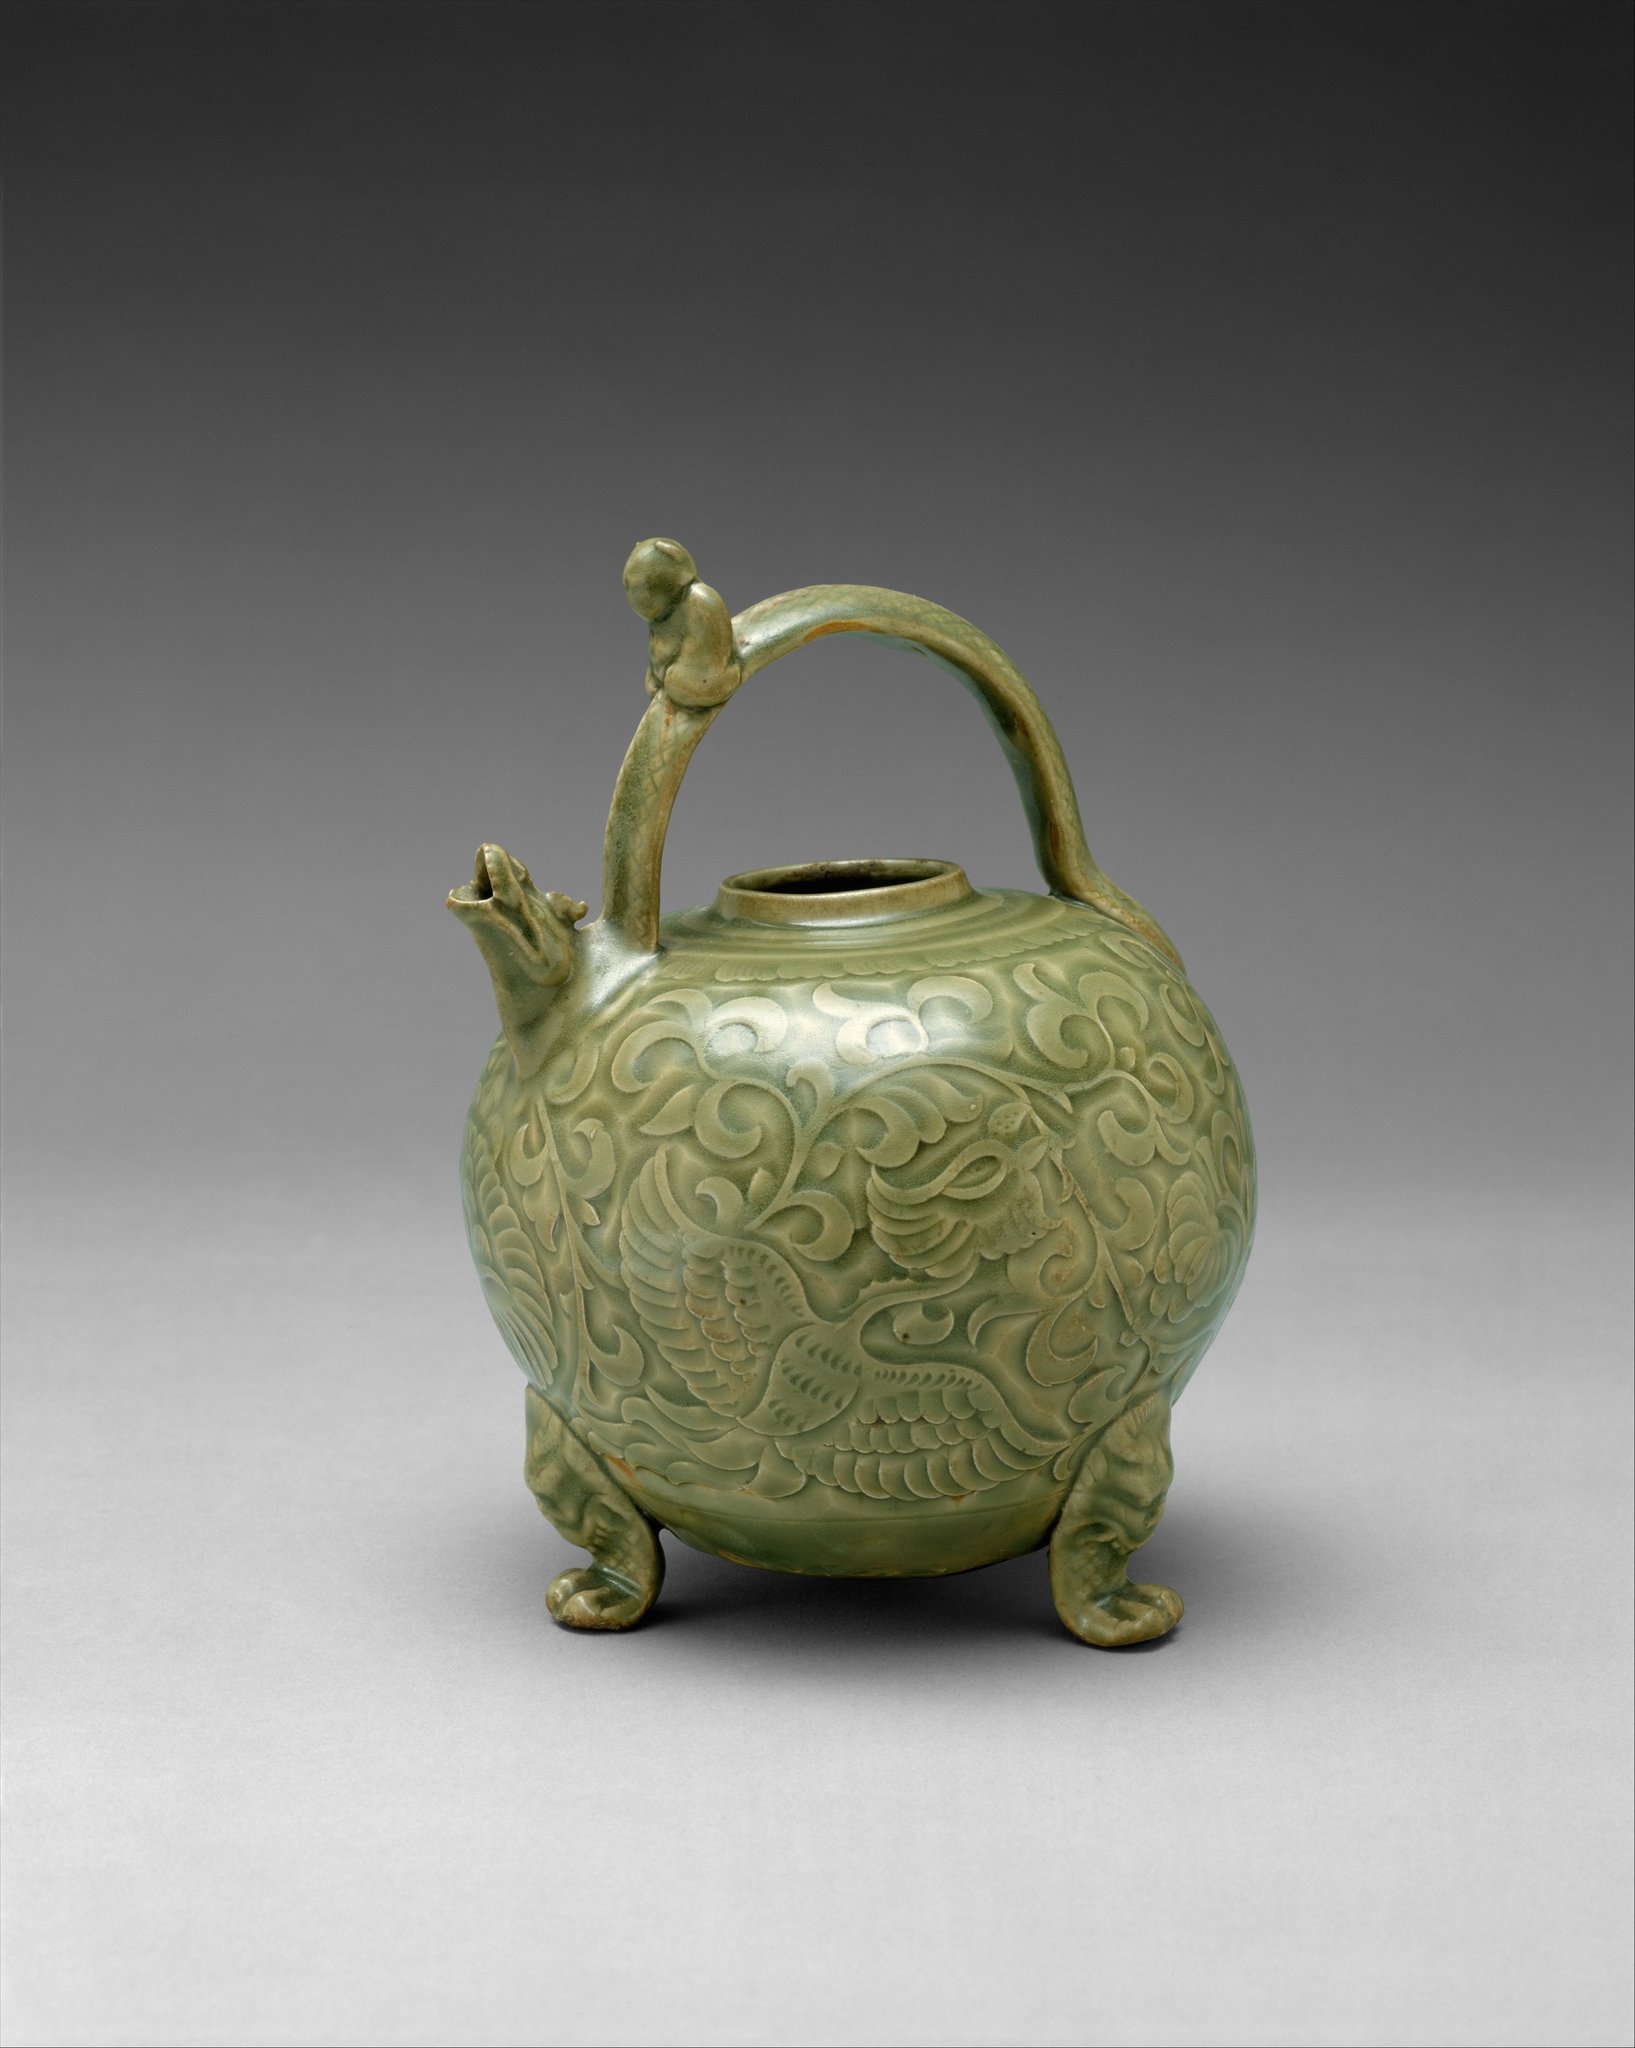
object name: ewer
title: Ewer with phoenix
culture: chinese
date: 1001-1200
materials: ceramic glaze, glaze, stoneware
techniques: carving, incising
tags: phoenix